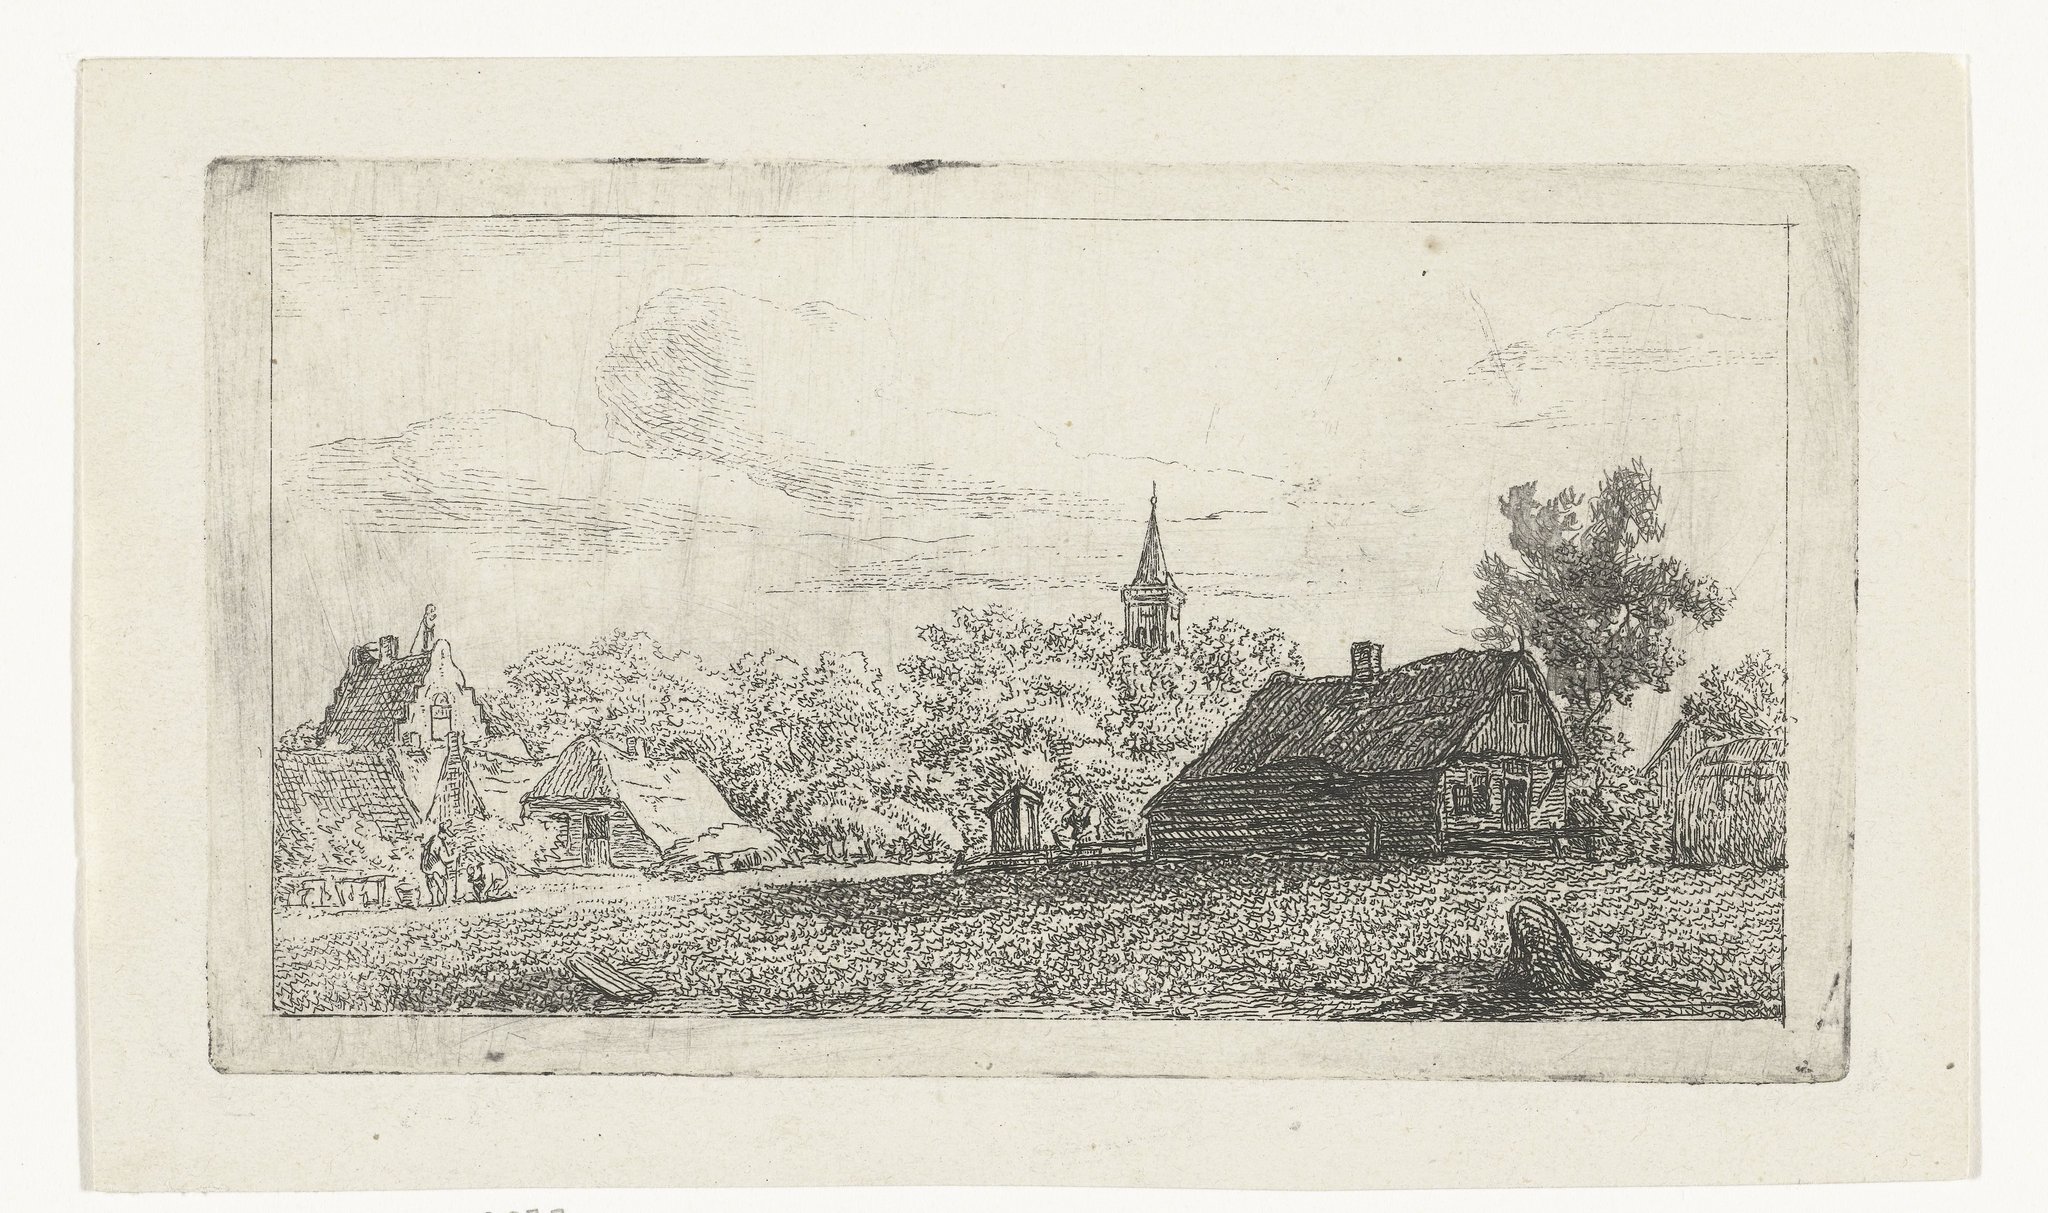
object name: print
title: Dorpsgezicht met kerktoren tussen bomen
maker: johannes franciscus christ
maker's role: draughtsman, print maker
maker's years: 1790-1845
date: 1810-1830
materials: paper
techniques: etching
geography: nijmegen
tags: village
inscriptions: collector's mark: Lugt 2228